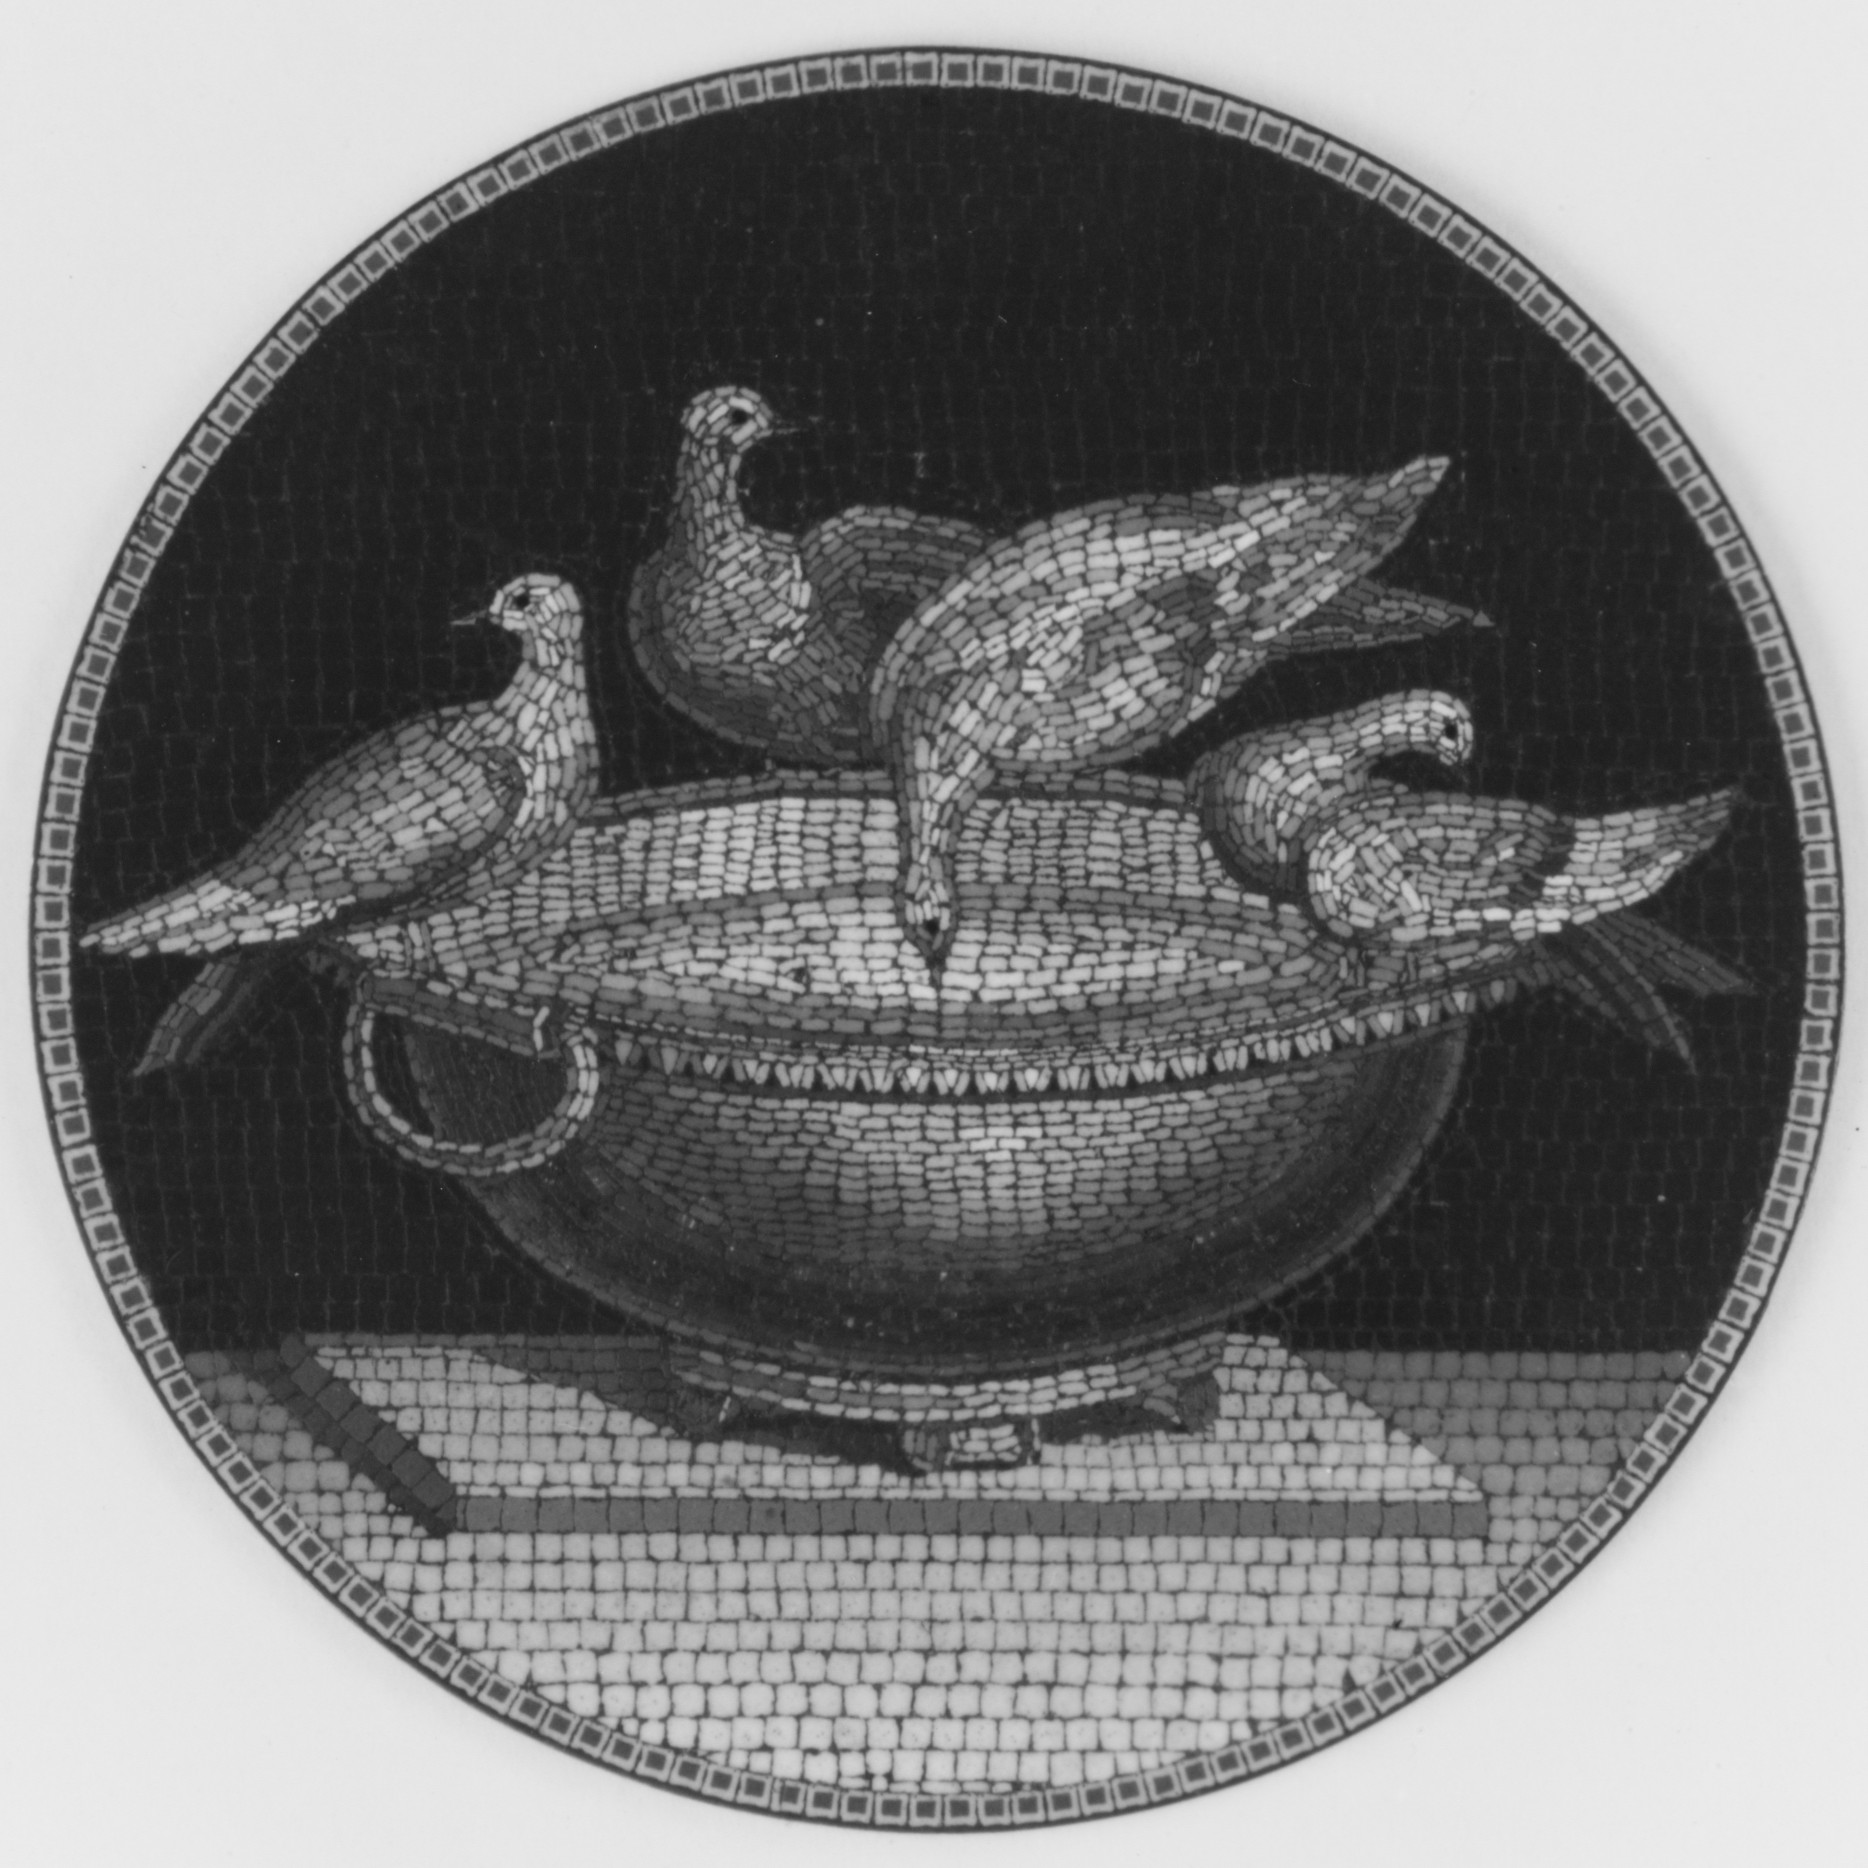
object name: roundel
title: Doves of Pliny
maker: giacomo raffaelli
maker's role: artist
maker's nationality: italian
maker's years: 1753-1836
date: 1783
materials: bronze, glass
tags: doves